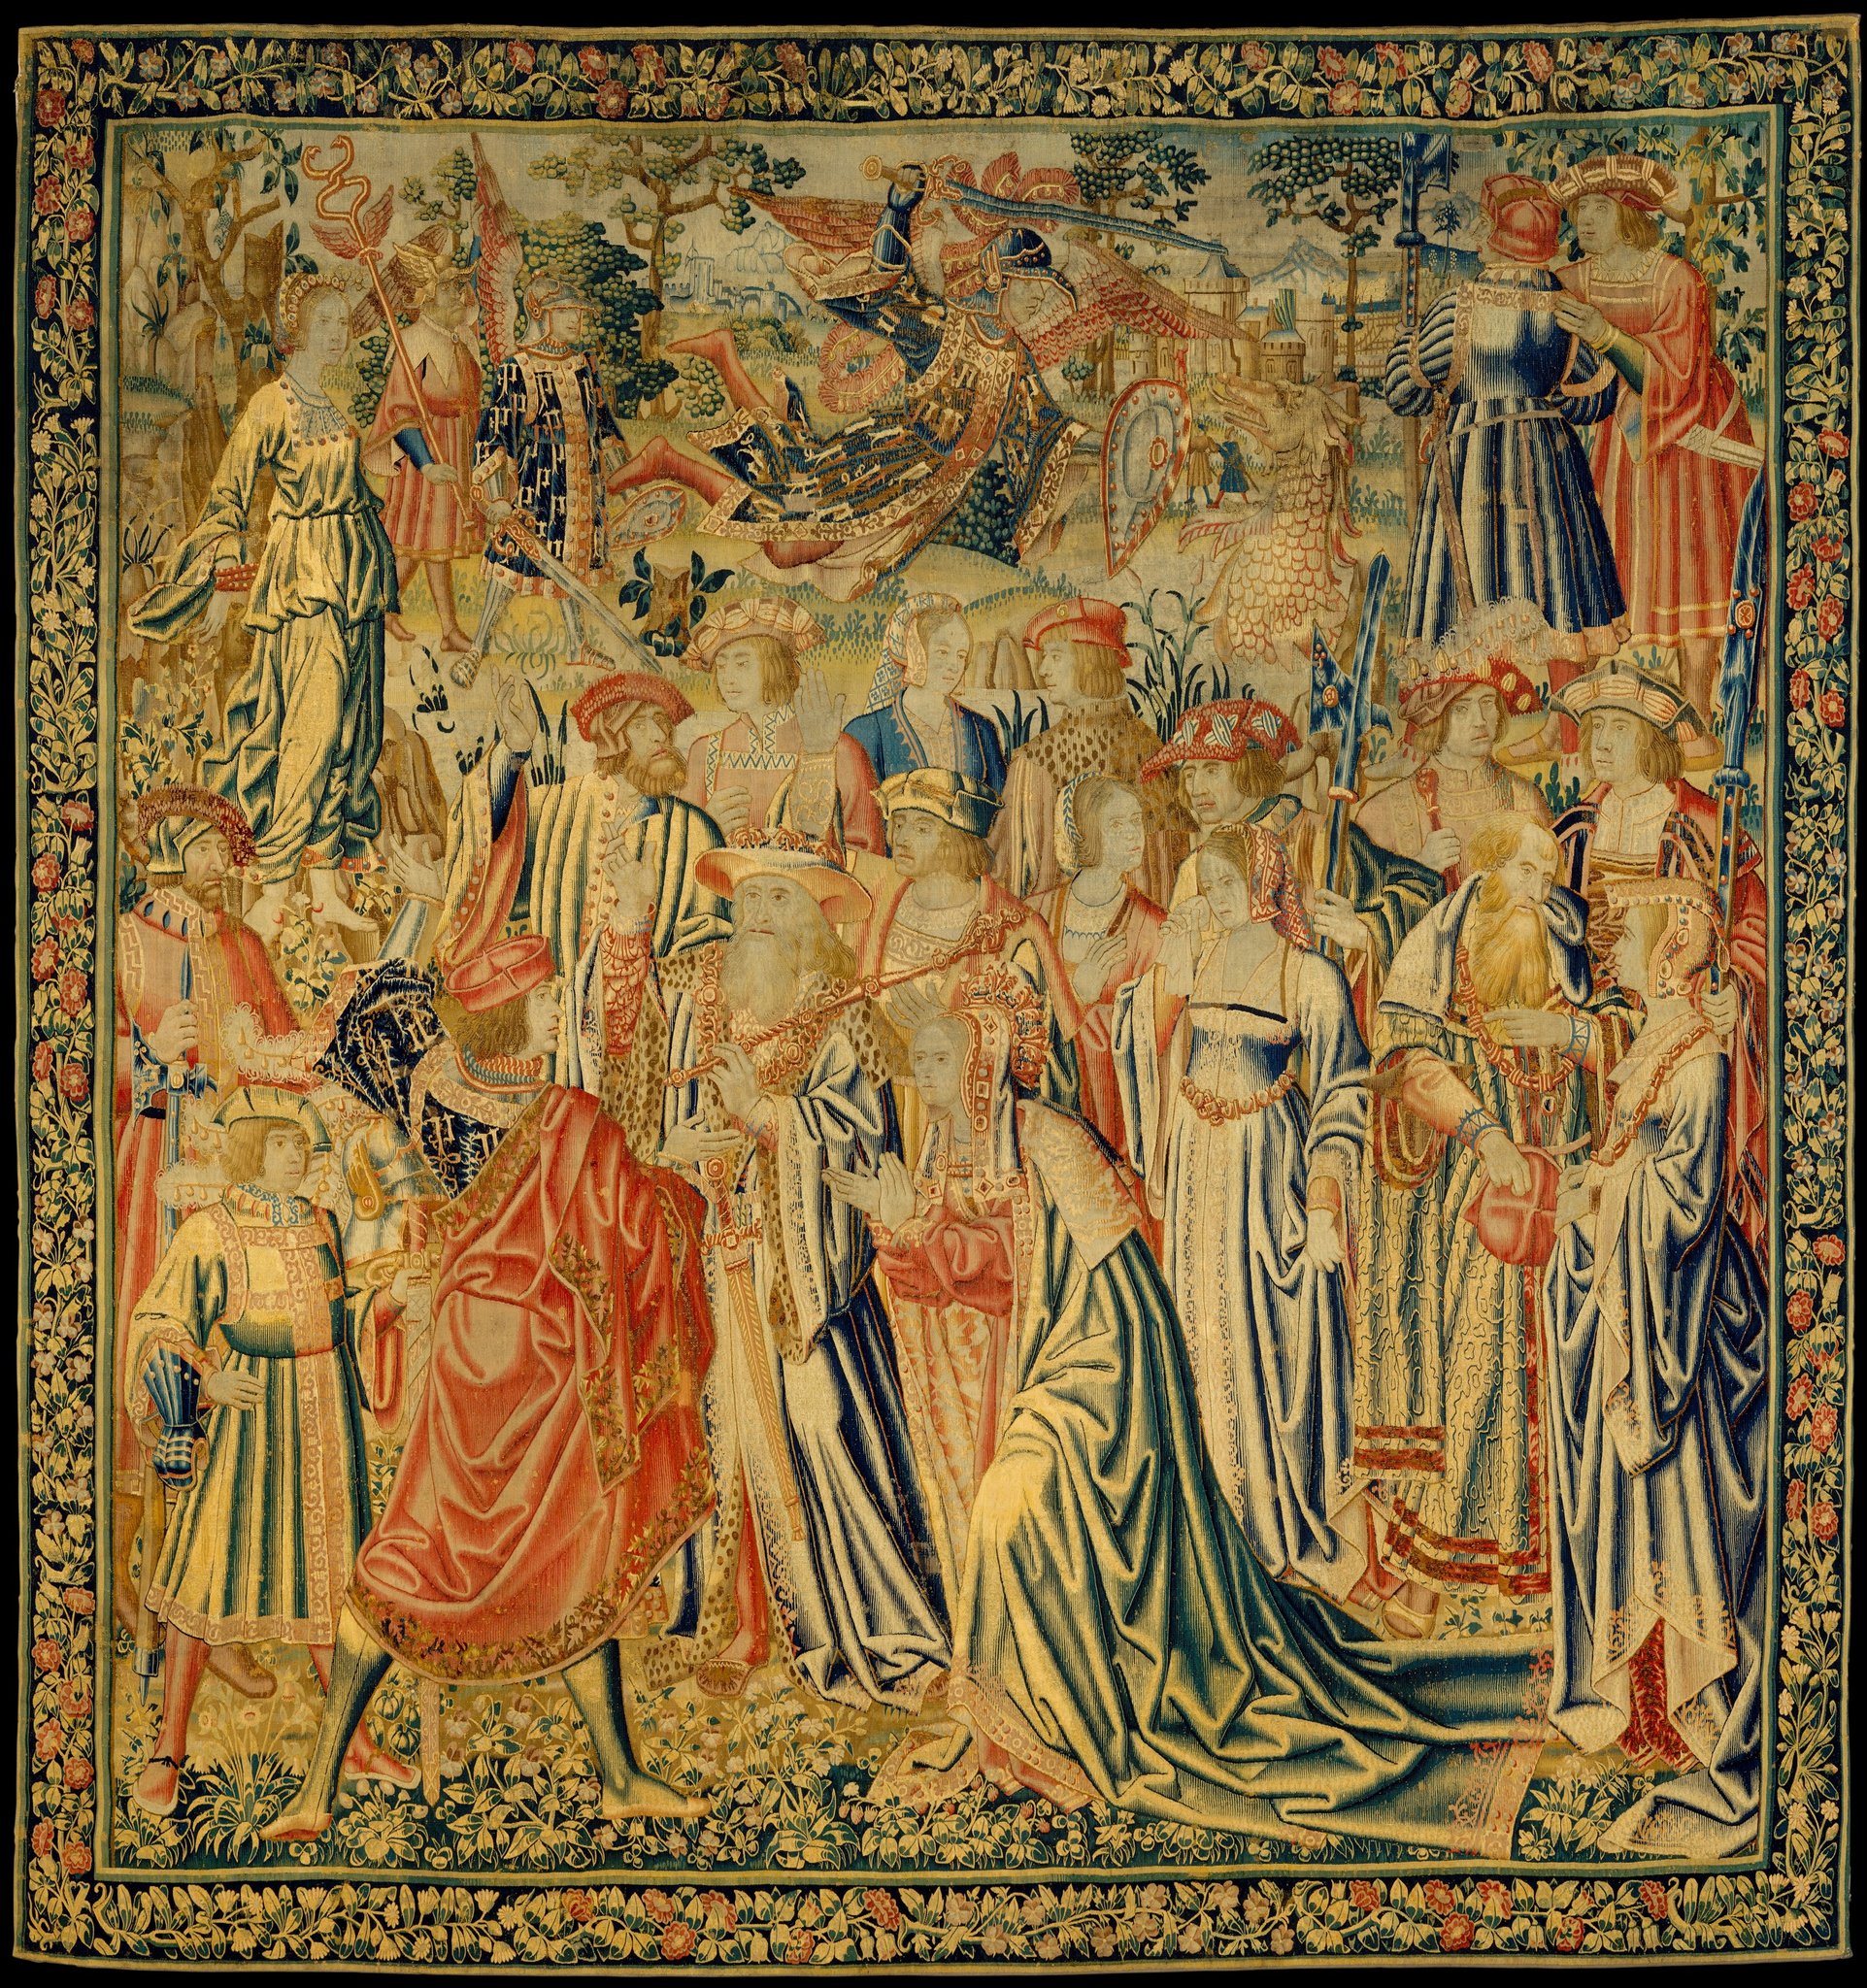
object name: tapestry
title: Perseus Rescues Andromeda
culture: south netherlandish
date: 1515-1525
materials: silk, wool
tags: swords,men,women,andromeda,perseus,dragons